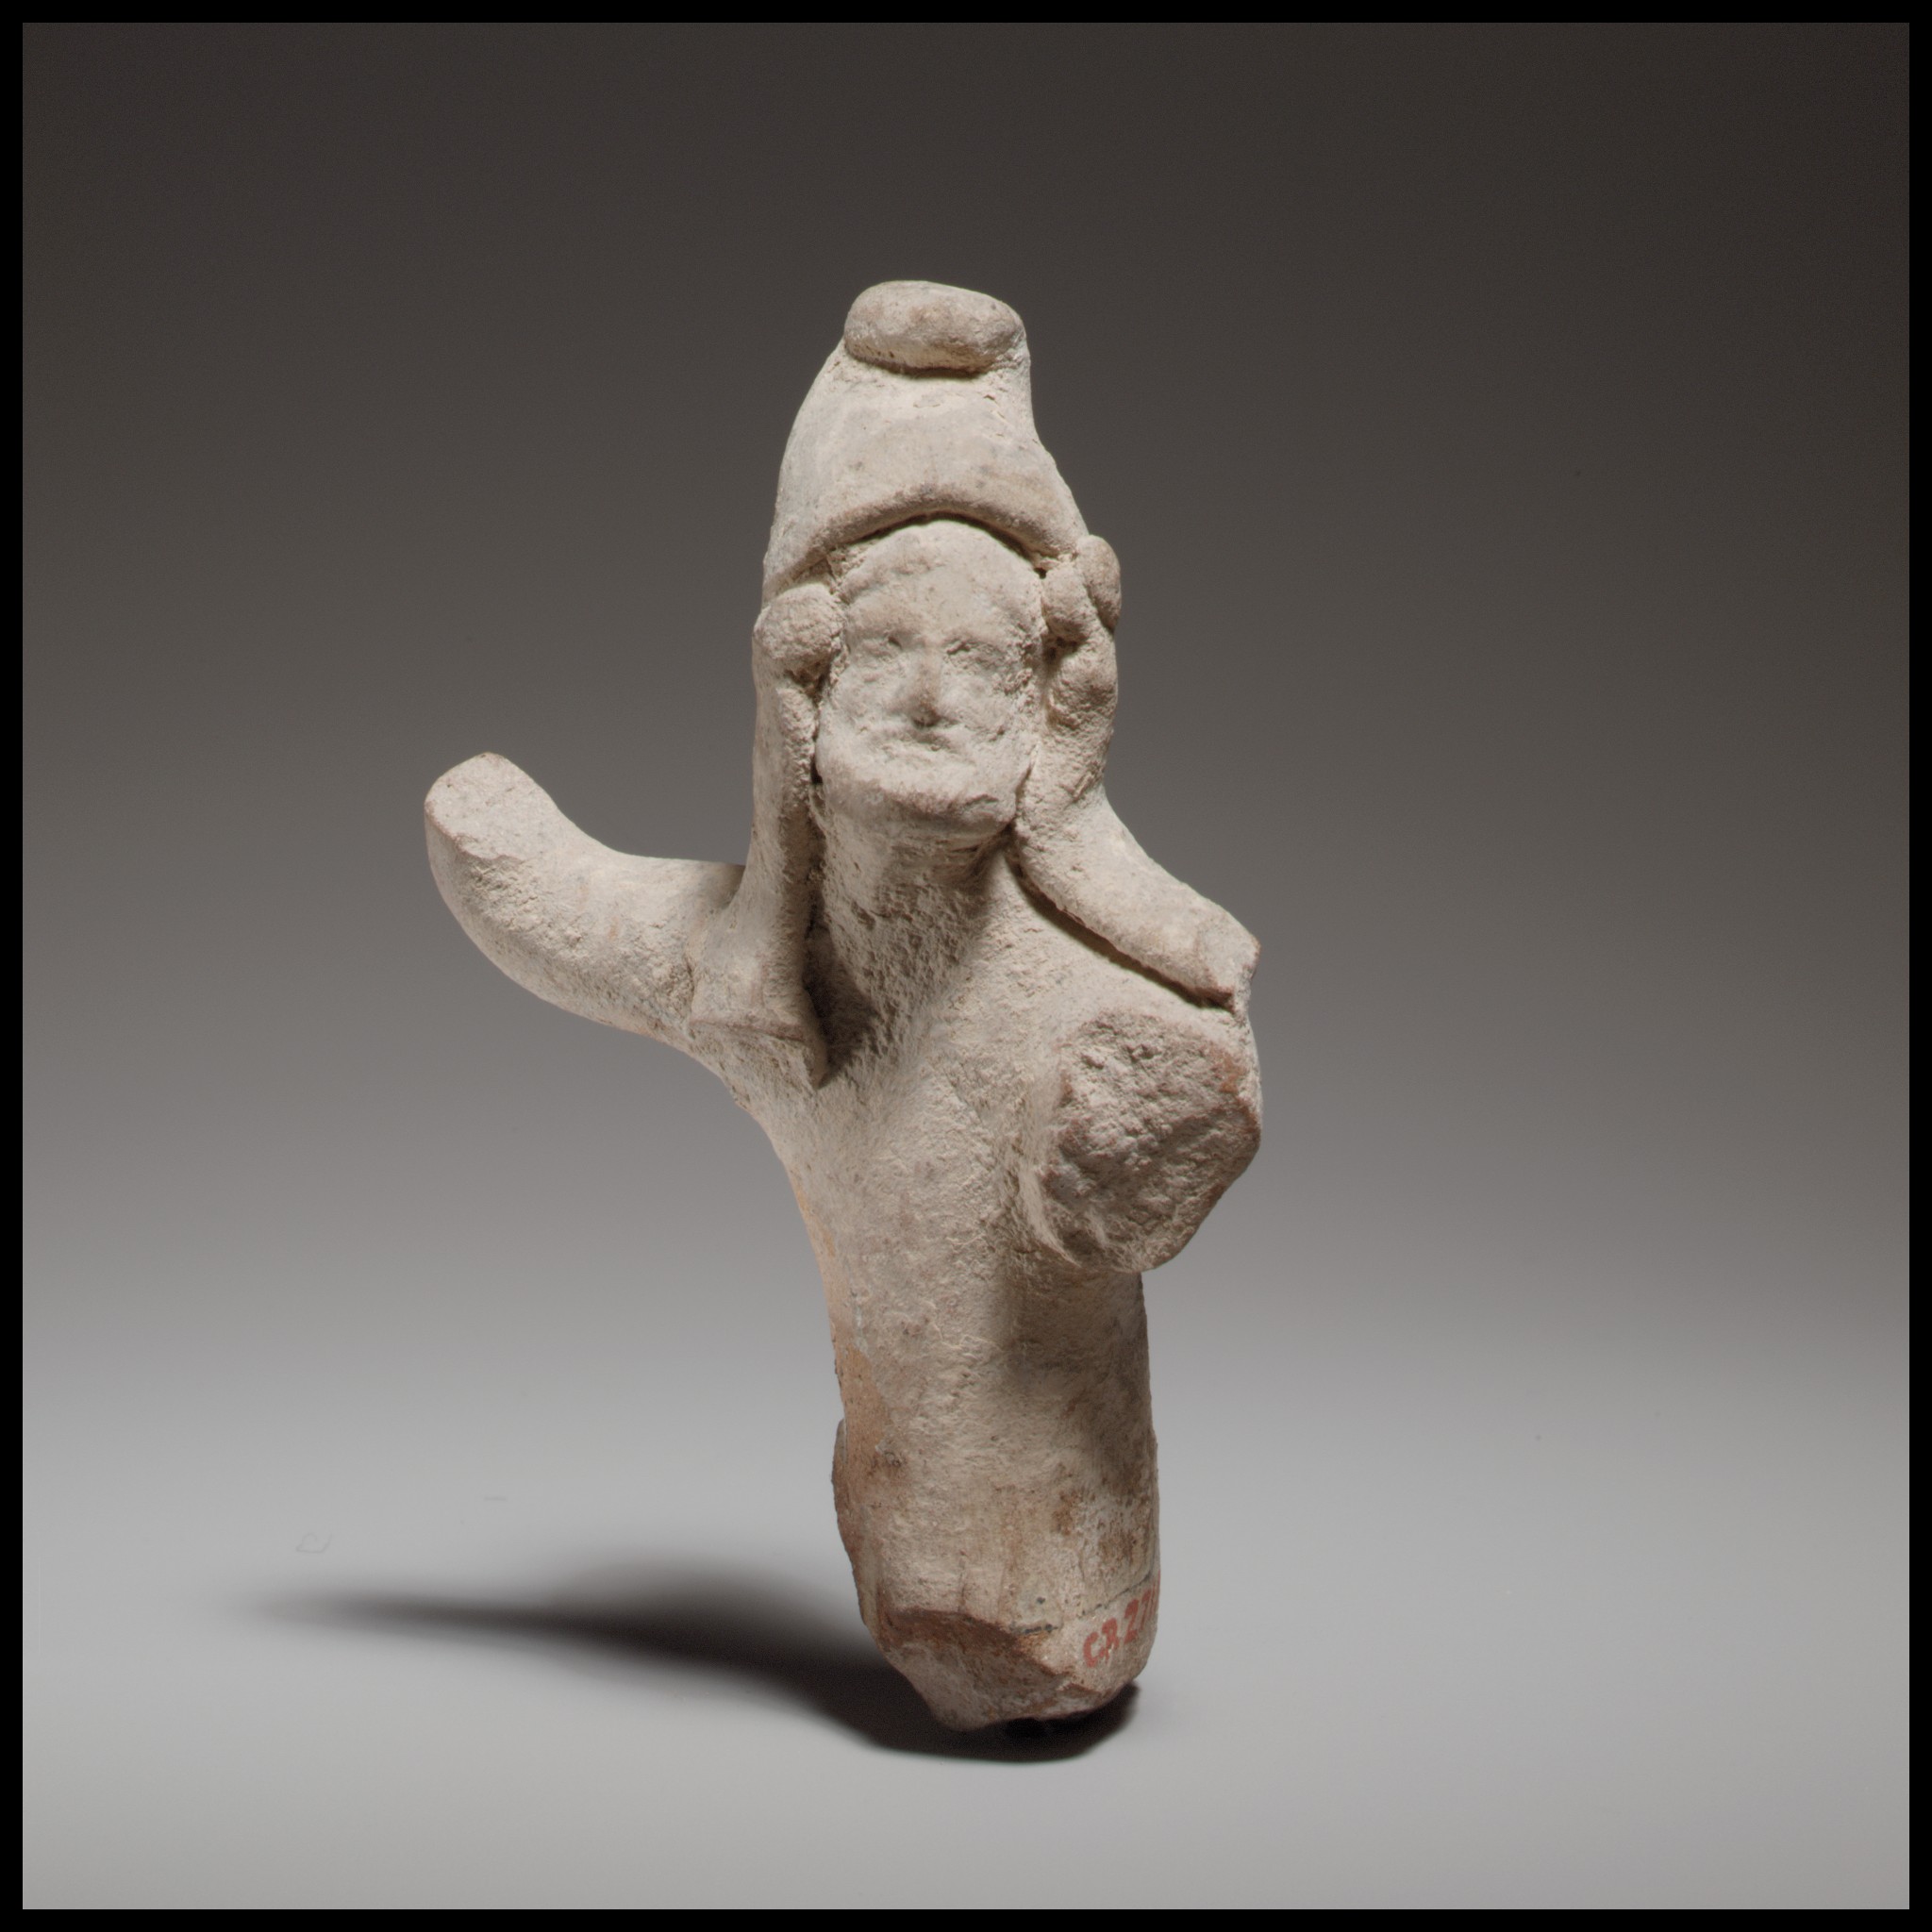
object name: statue of a warrior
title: Horseman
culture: cypriot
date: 400-201 BCE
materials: terracotta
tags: faces